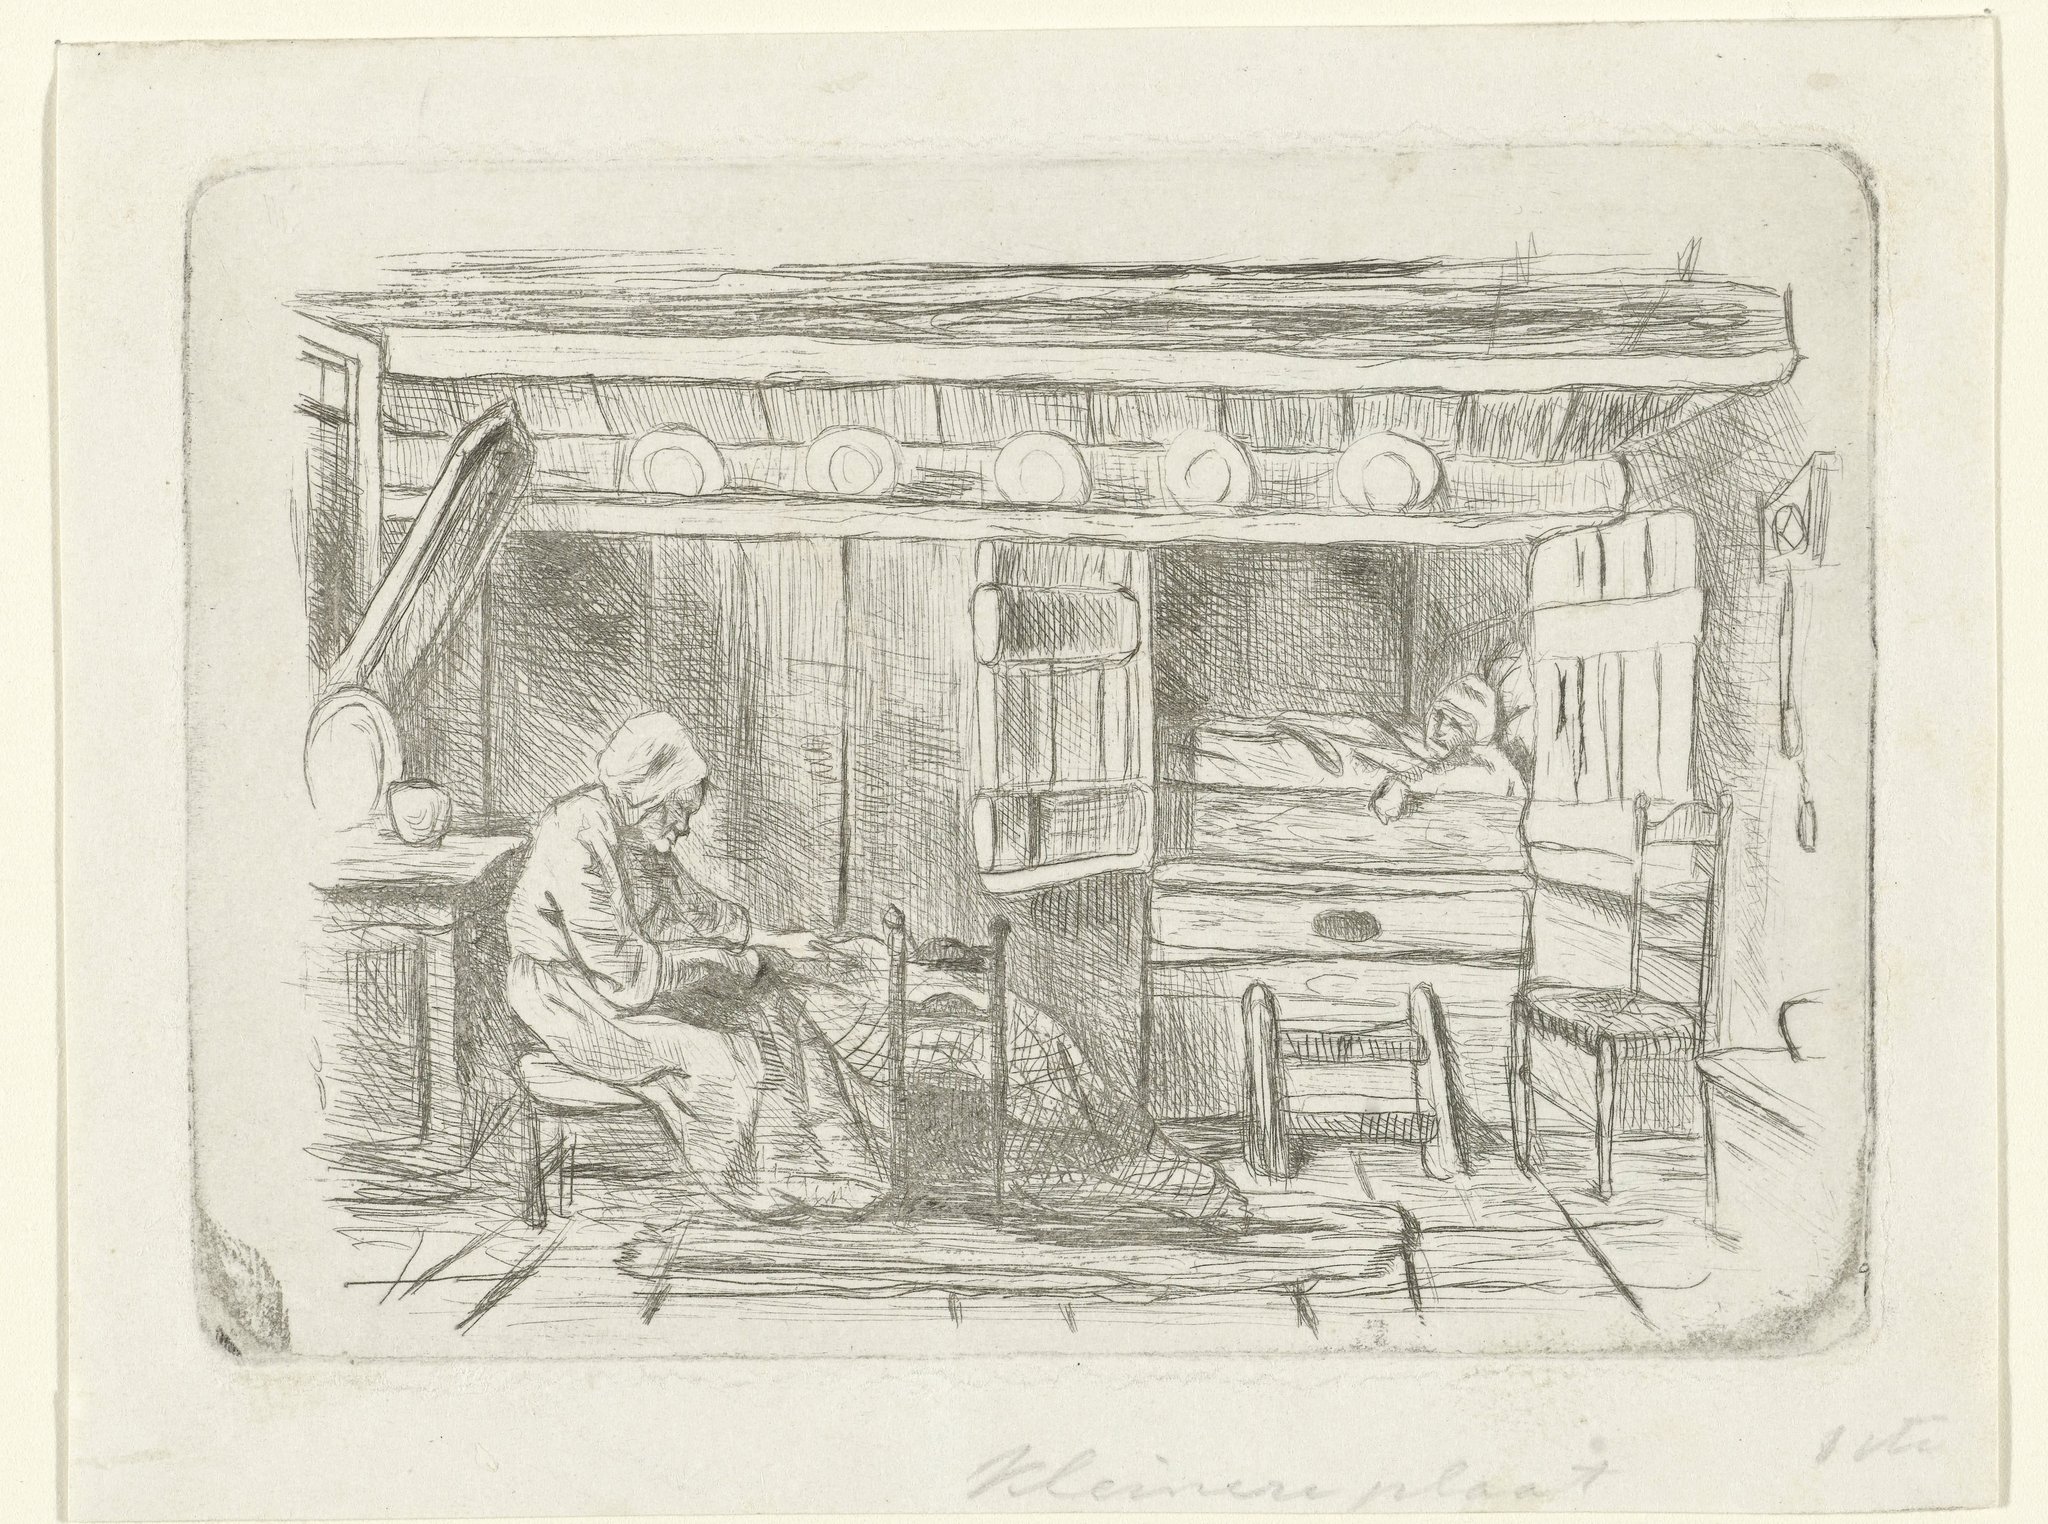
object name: print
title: Twee figuren in een interieur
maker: jozef israëls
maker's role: draughtsman, painter, print maker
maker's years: 1824-1911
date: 1835-1888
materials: paper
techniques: etching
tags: adult woman, interior of the house, (other forms of) needlework, e.g.: crocheting, knitting, embroidering, built-in bedstead (dutch: 'bedstee')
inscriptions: collector's mark: Lugt 2228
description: Links een vrouw zittend op een stoel in een interieur. Zij verstelt netten. In de bedstee ligt een oude man. Boven de bedstee hangen vijf borden aan de muur.